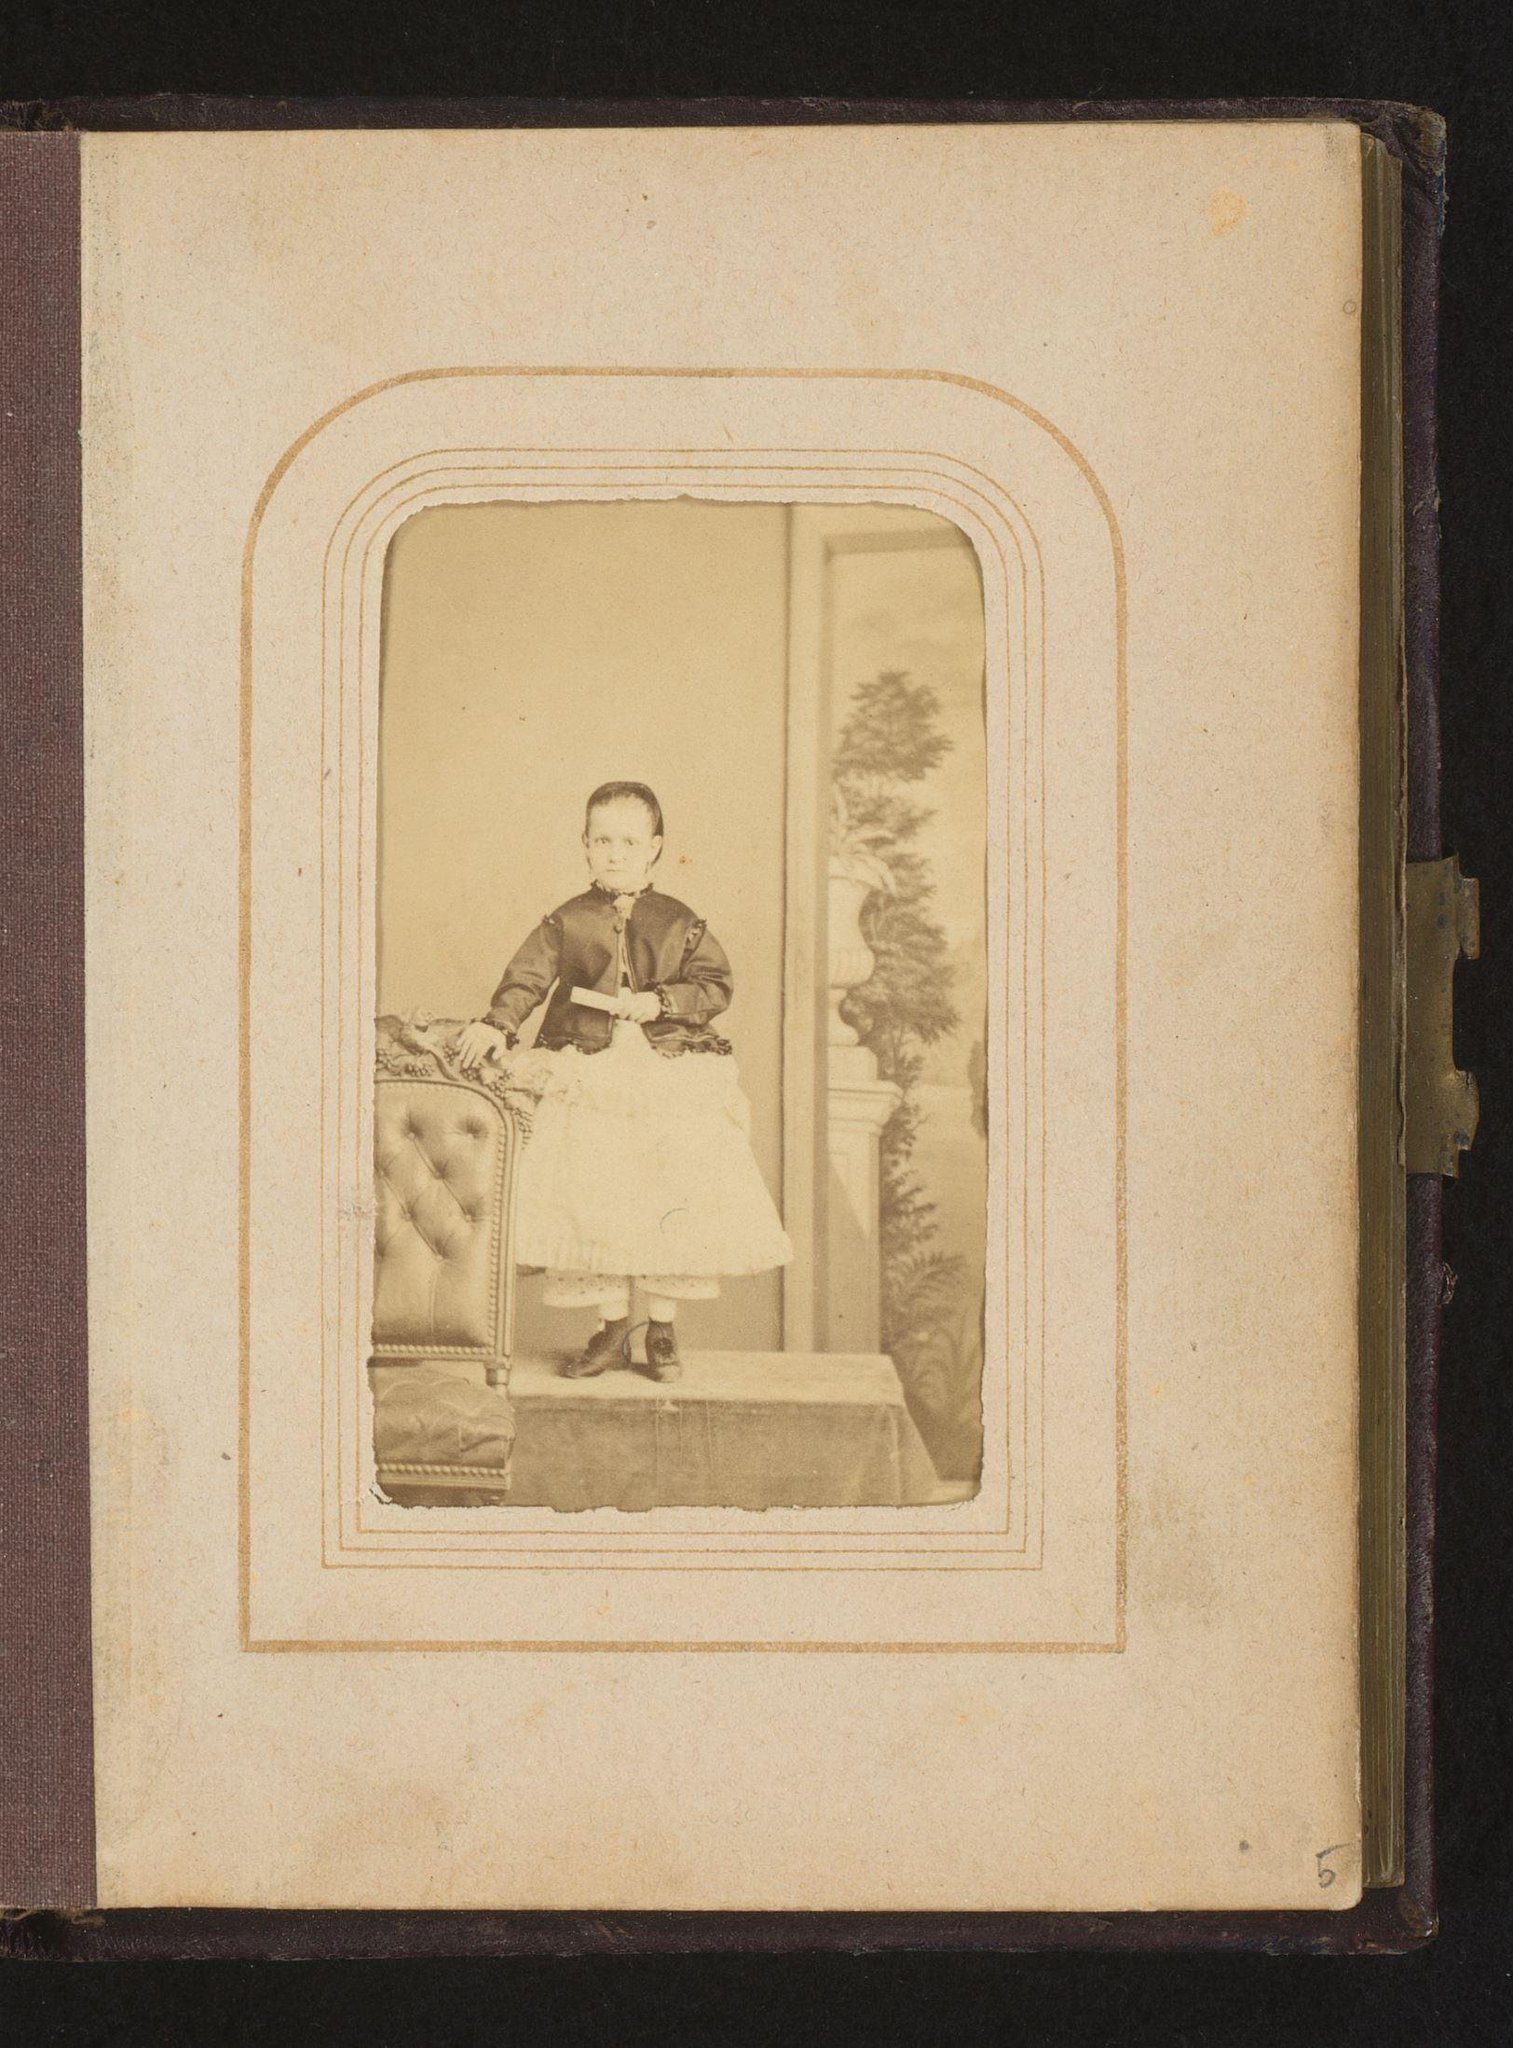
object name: photograph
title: Portret van een staand meisje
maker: Anonymous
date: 1860-1900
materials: cardboard, photographic support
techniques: albumen print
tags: girl (child between toddler and youth)